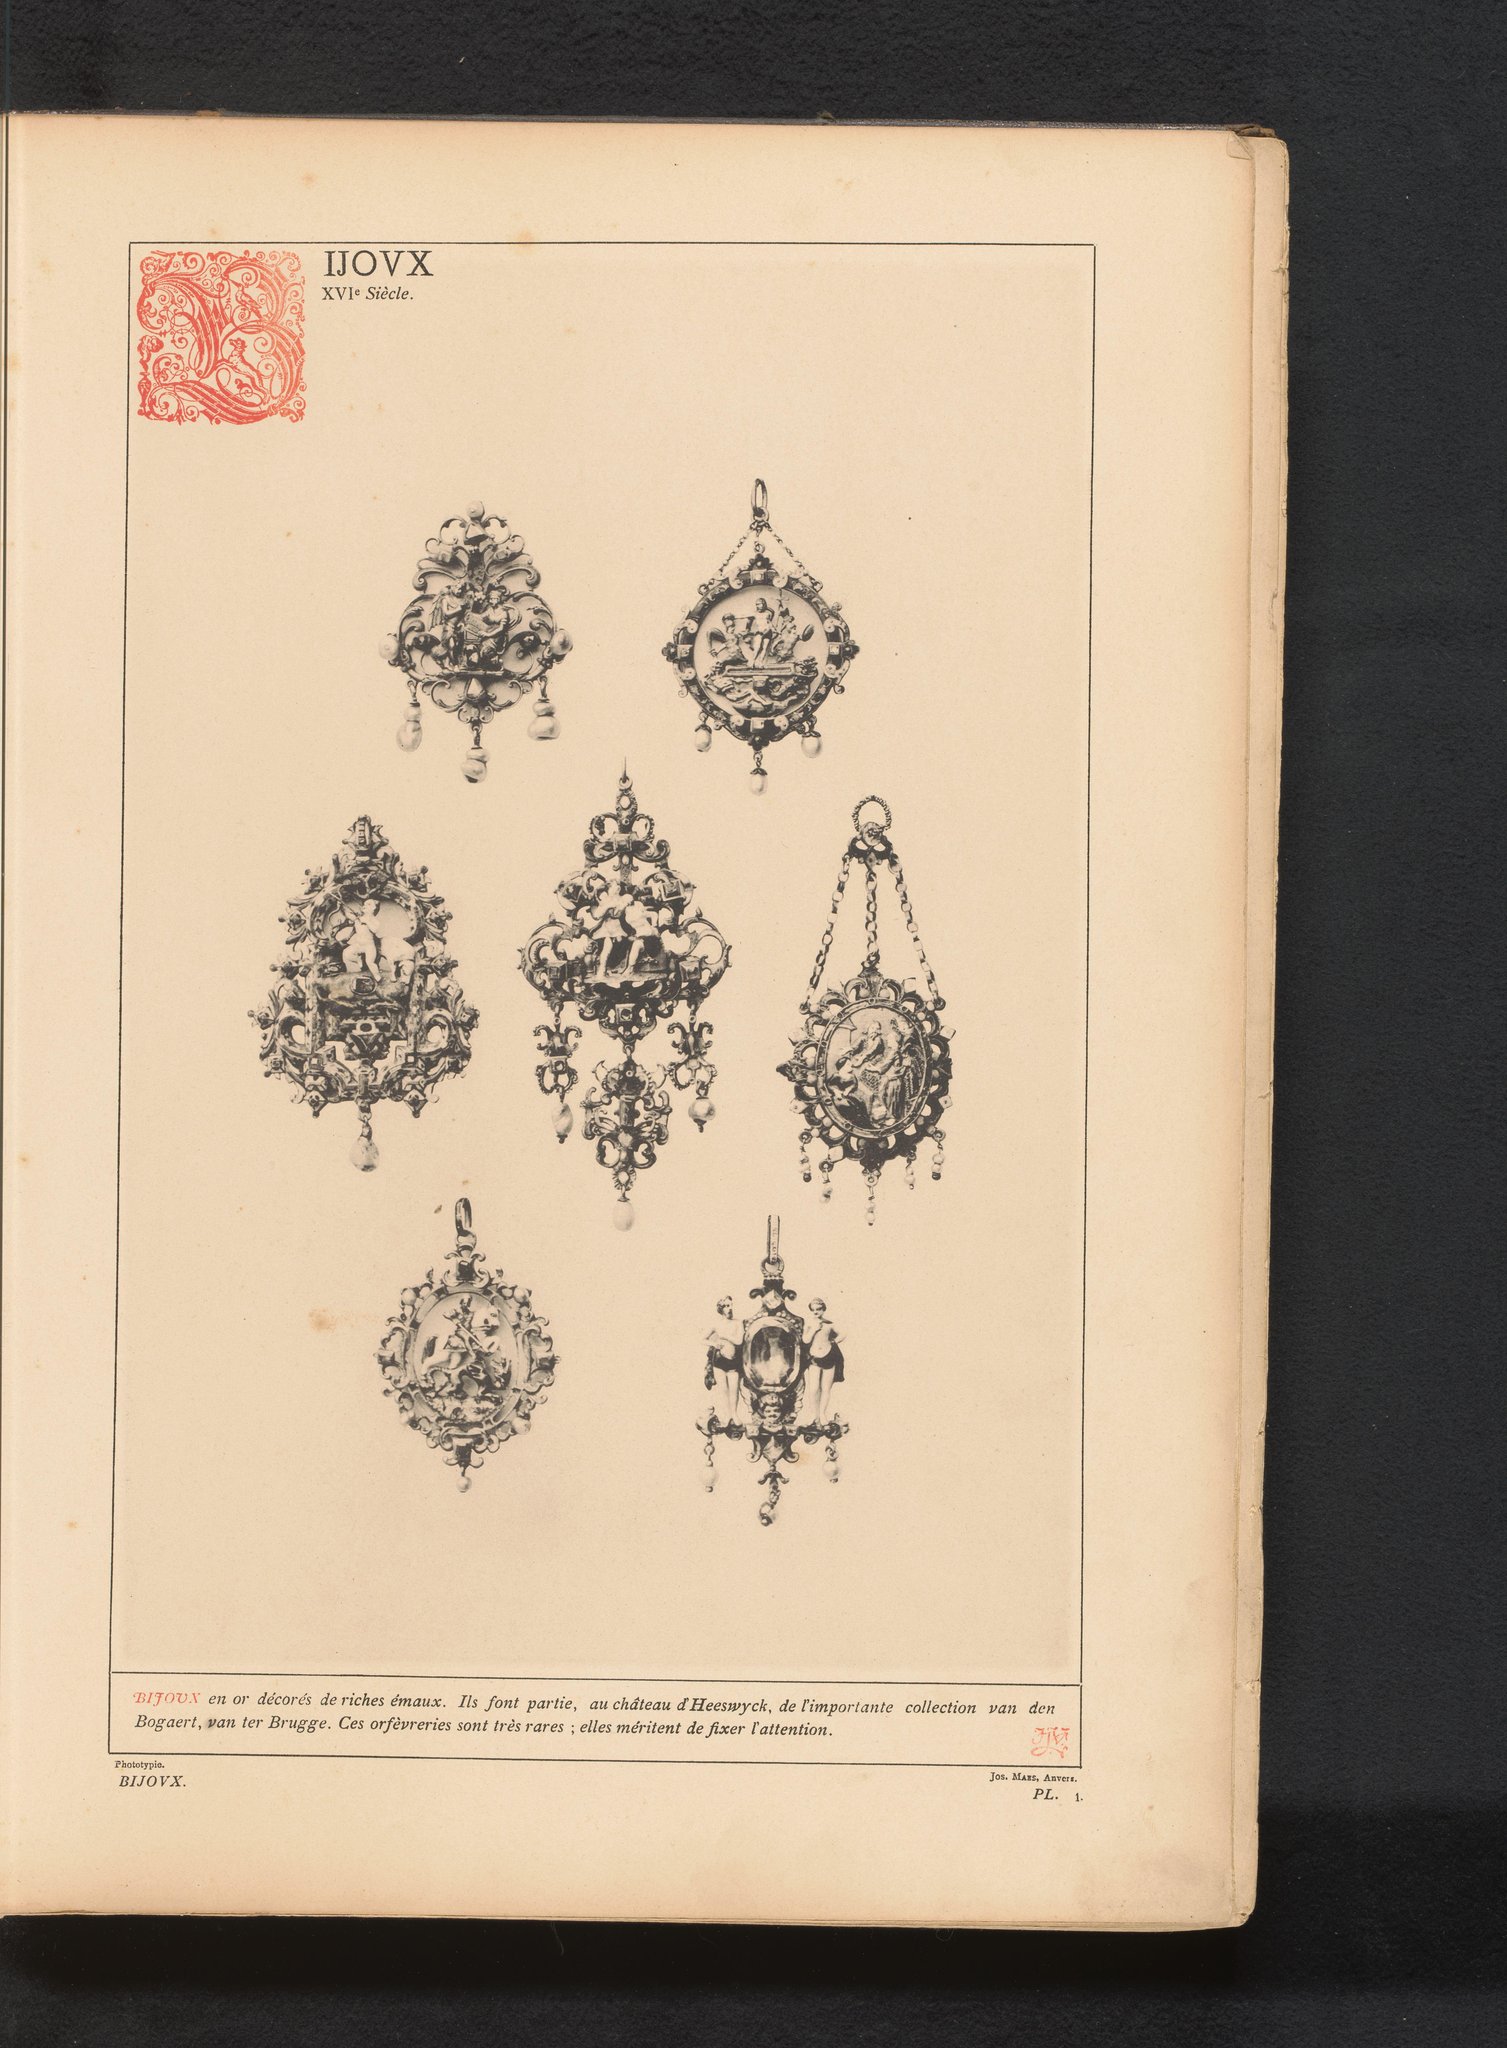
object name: photomechanical print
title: Gouden hangers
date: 1881-1889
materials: paper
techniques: photograph, photolithography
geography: antwerp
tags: ornaments, jewels, capital (~ column, pillar)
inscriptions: inscription: ‘BIJOUX en or (...)’, monogram: ‘JJvY’, inscription: ‘BIJOUX. PL.1.’